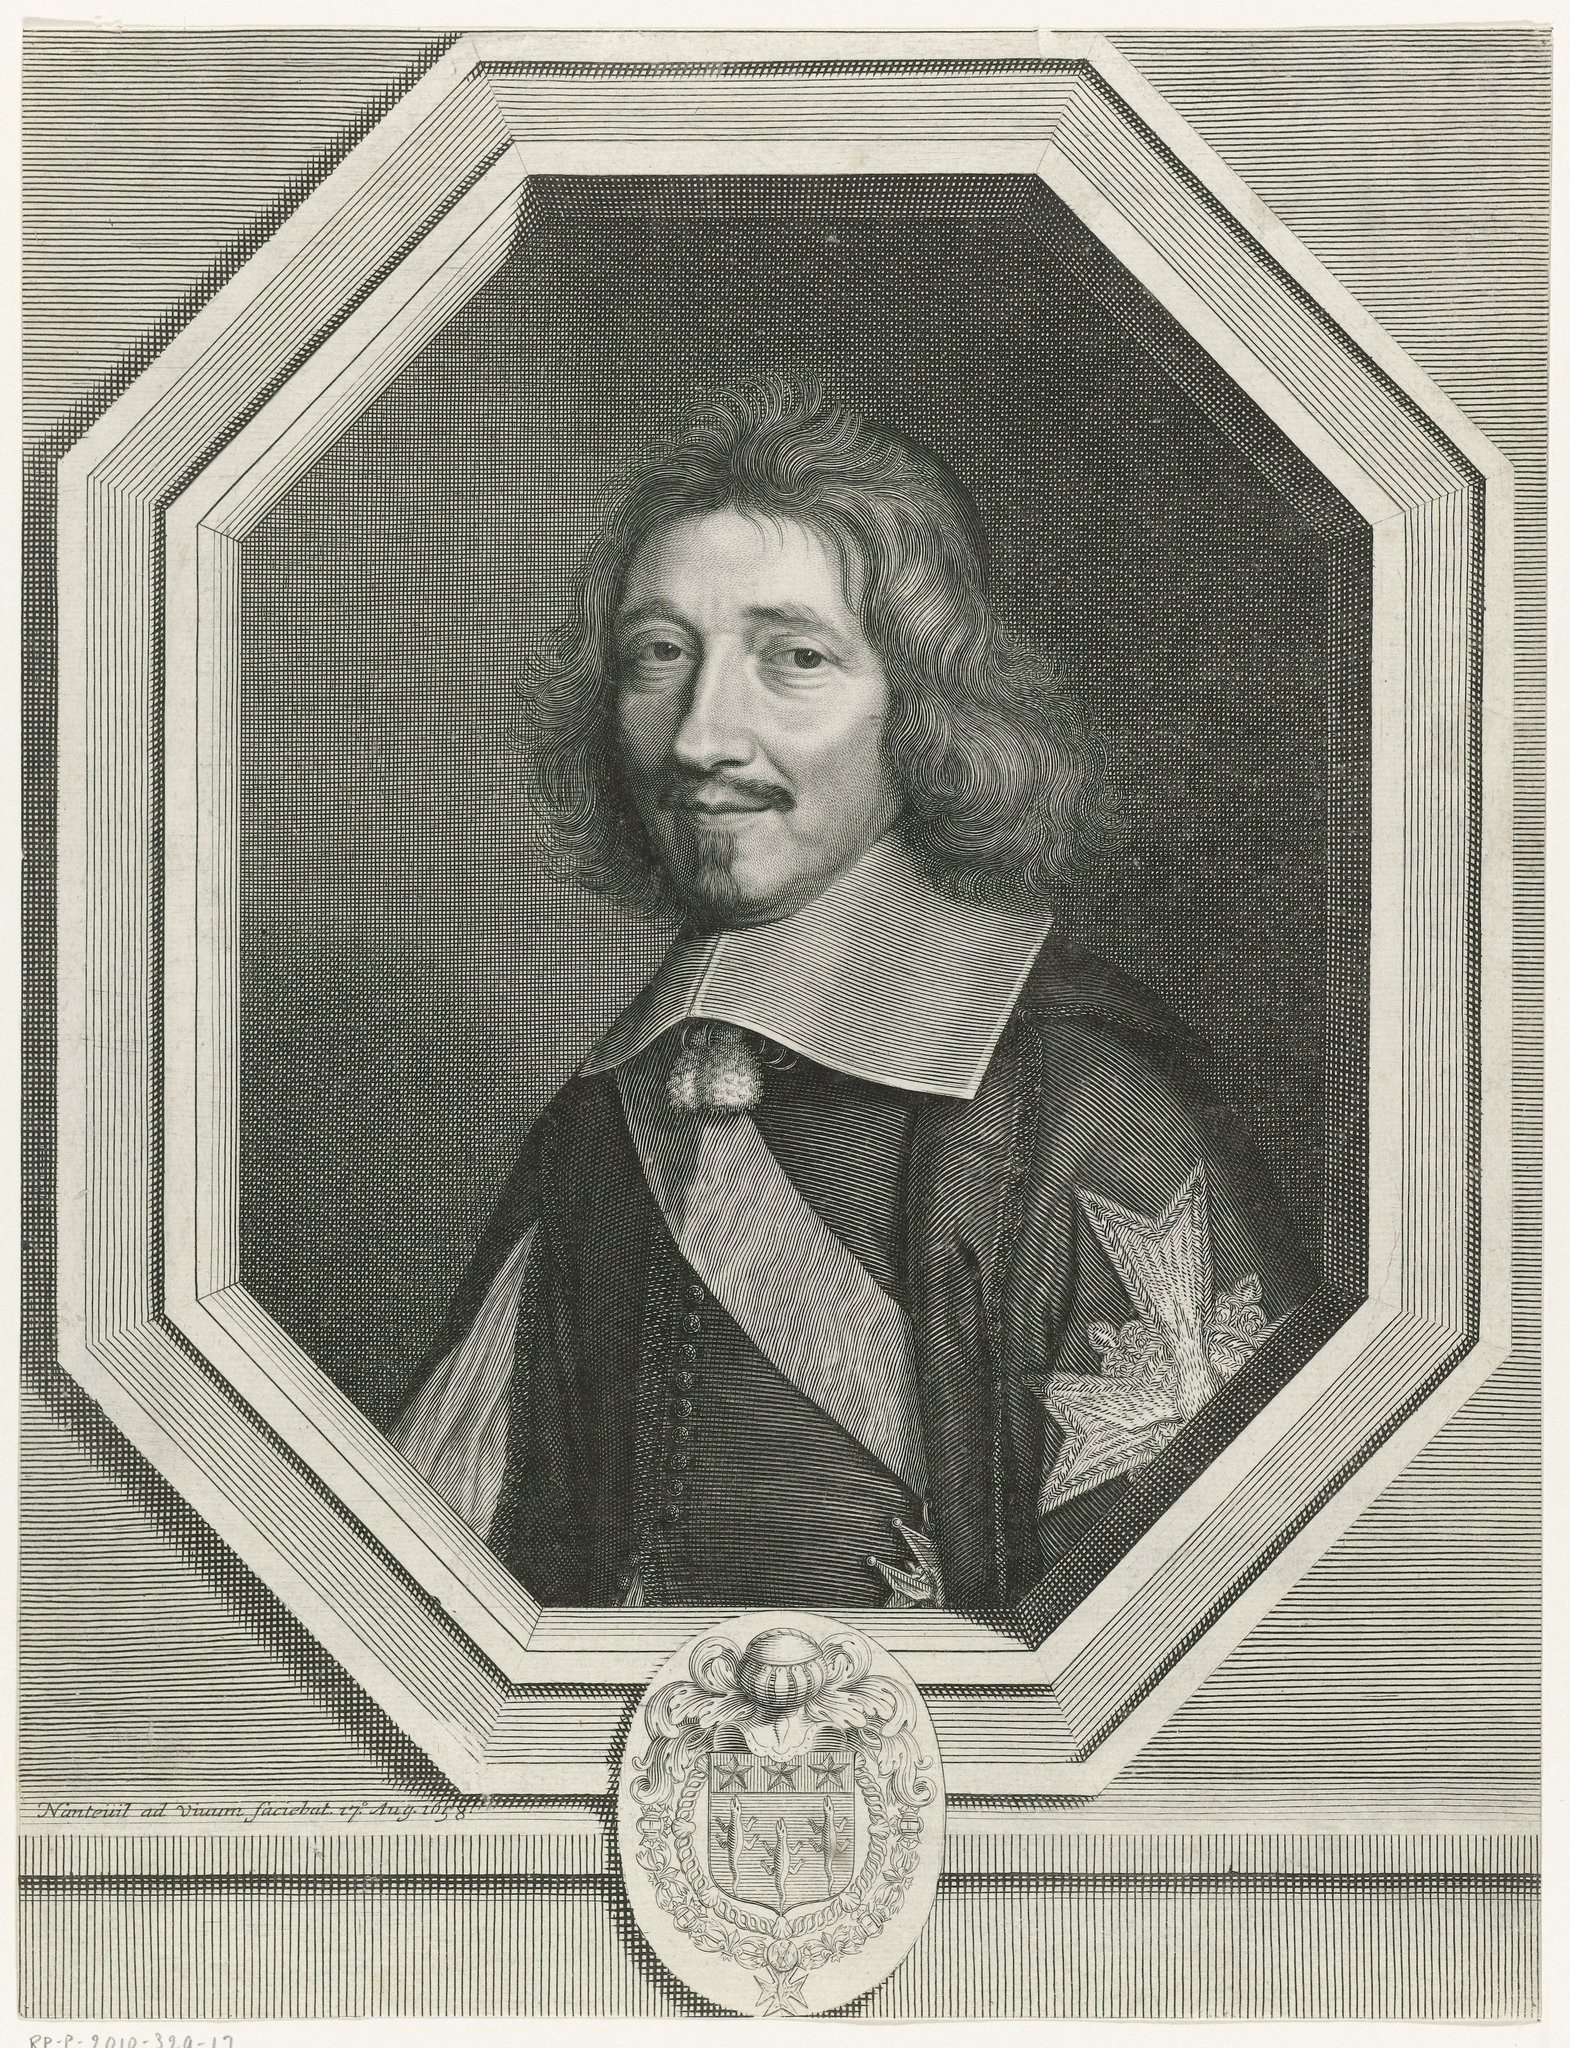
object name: print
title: Portret Charles-Maurice Le Tellier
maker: robert nanteuil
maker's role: print maker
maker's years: 1623-1678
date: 1658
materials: paper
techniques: engraving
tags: priest, charles-maurice le tellier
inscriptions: date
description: Buste naar links, in octagonale lijst met wapen middenonder.